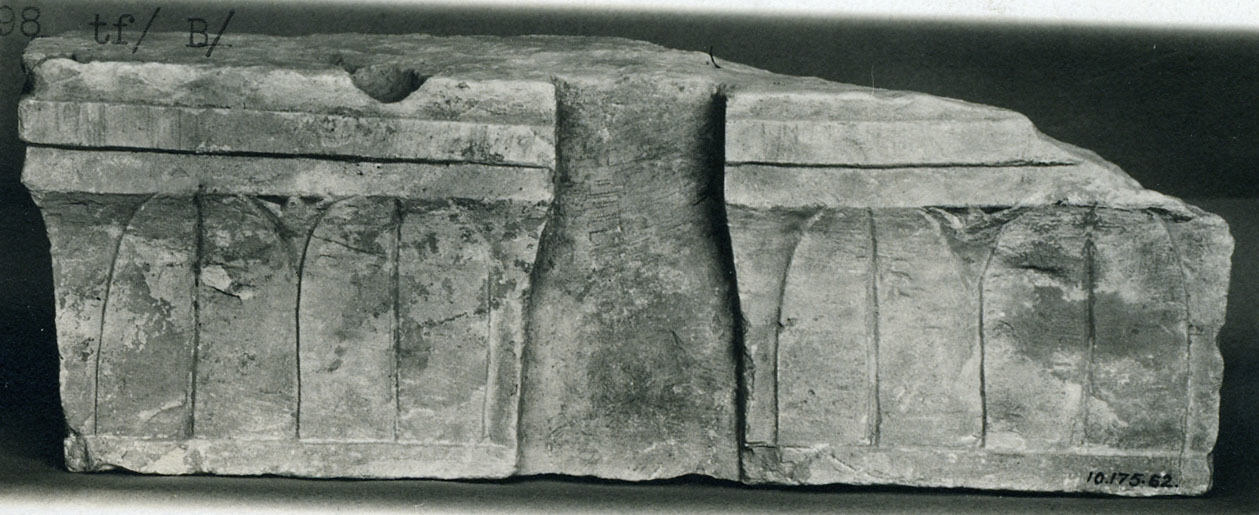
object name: capital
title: Capital with Palm Leaves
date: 501-700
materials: limestone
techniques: carving, relief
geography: egypt